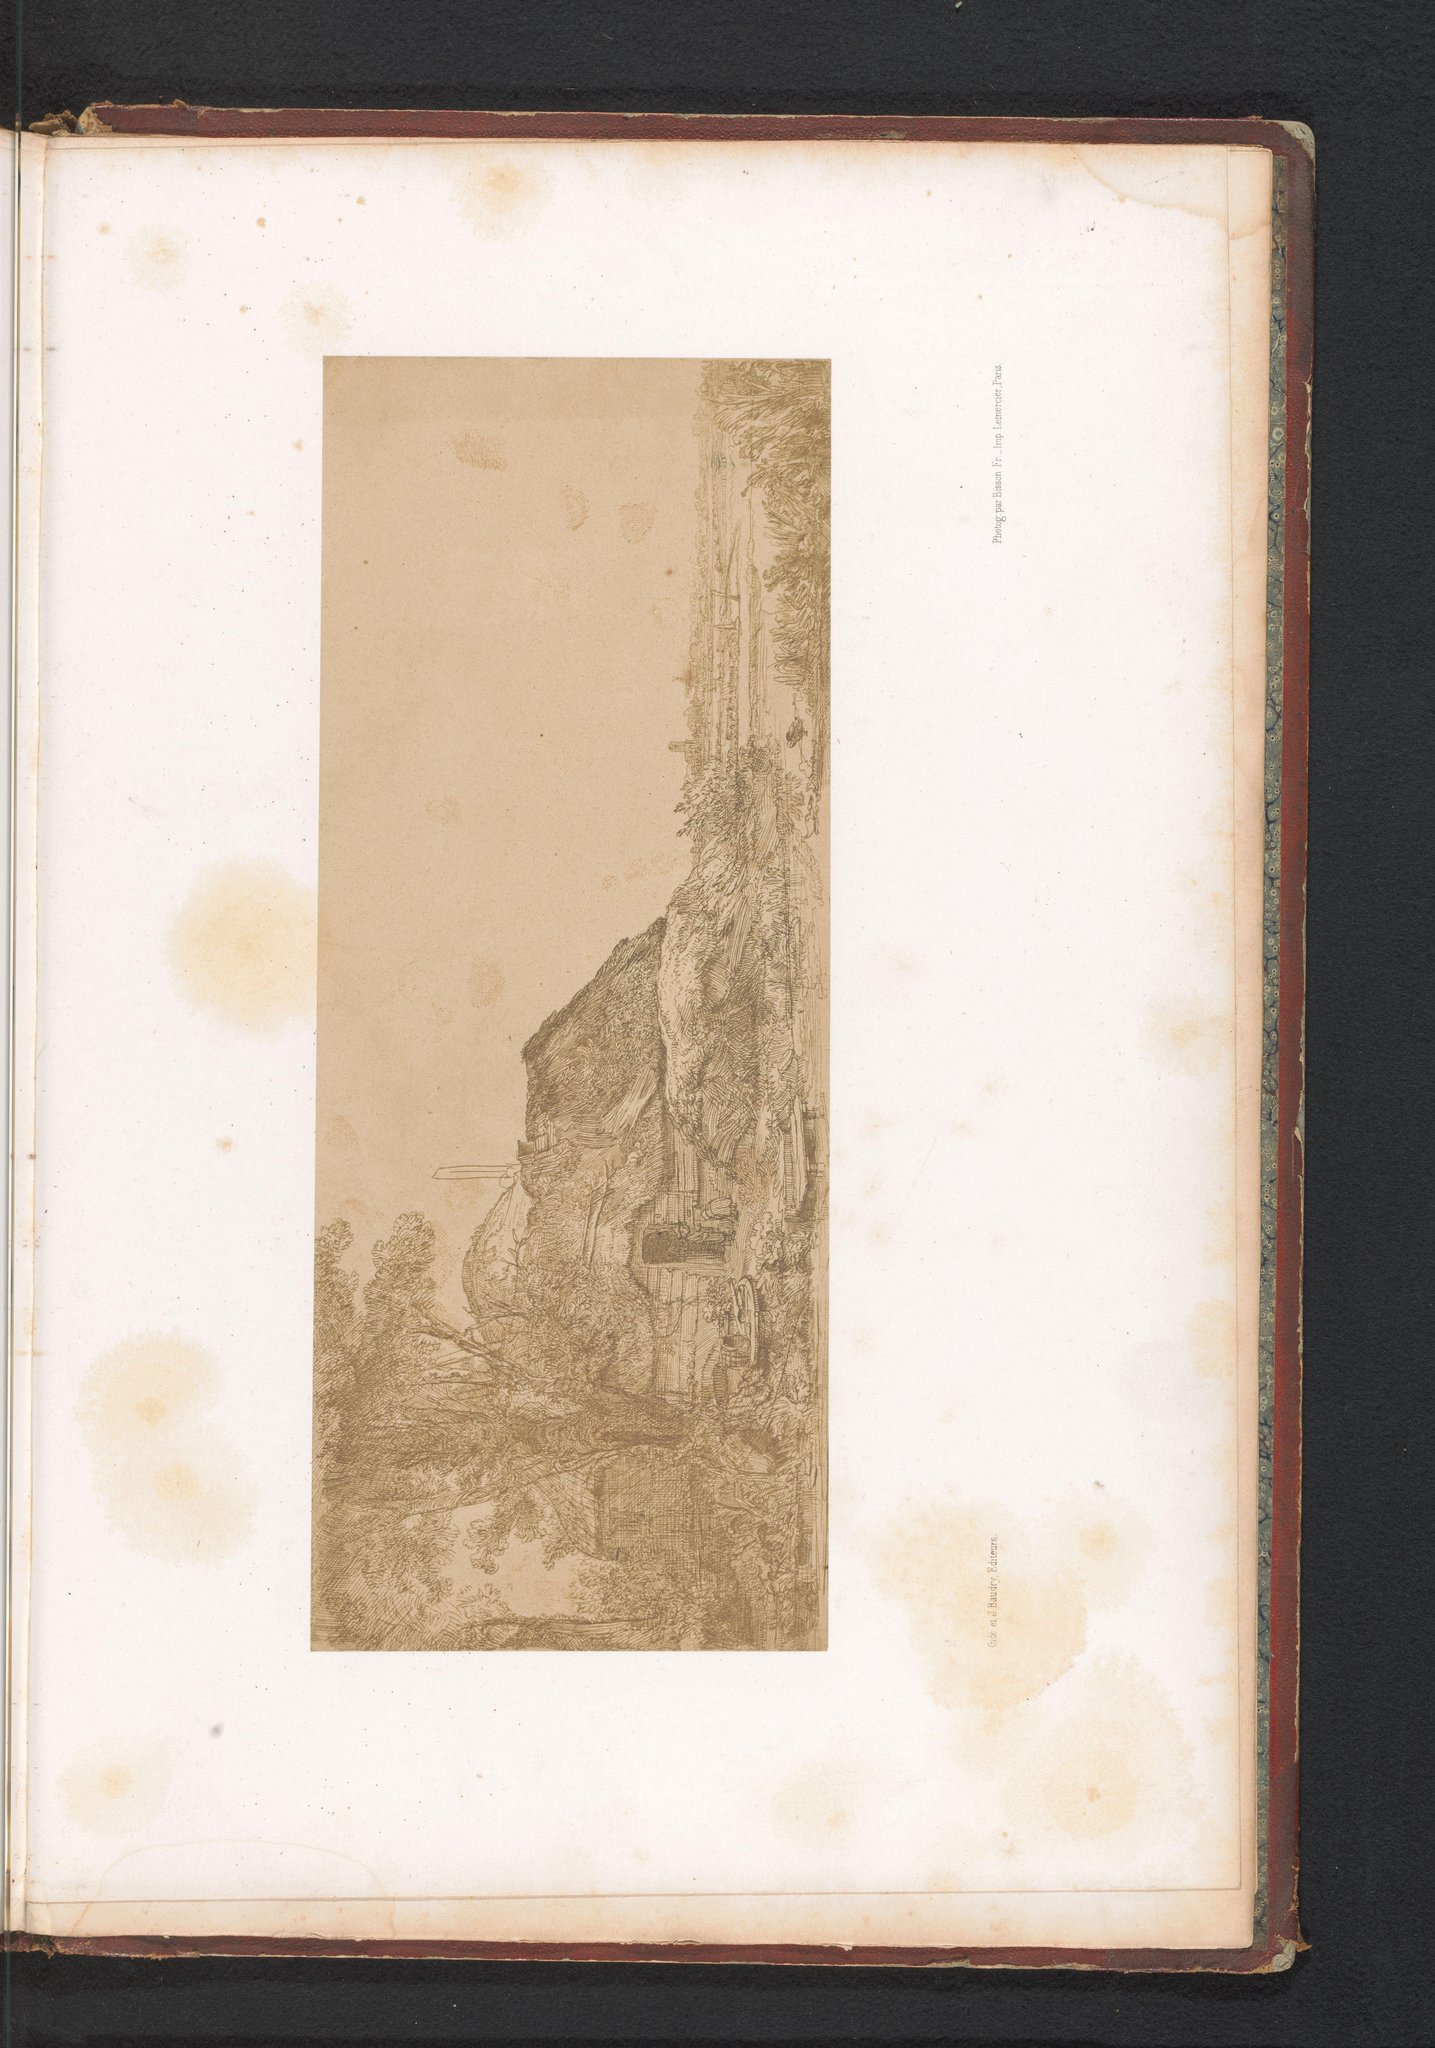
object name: page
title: Fotoreproductie van een ets van een landschap met boerderij en grote boom door Rembrandt van Rijn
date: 1848-1853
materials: photographic support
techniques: salted paper print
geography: paris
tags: trees, farm or solitary house in landscape